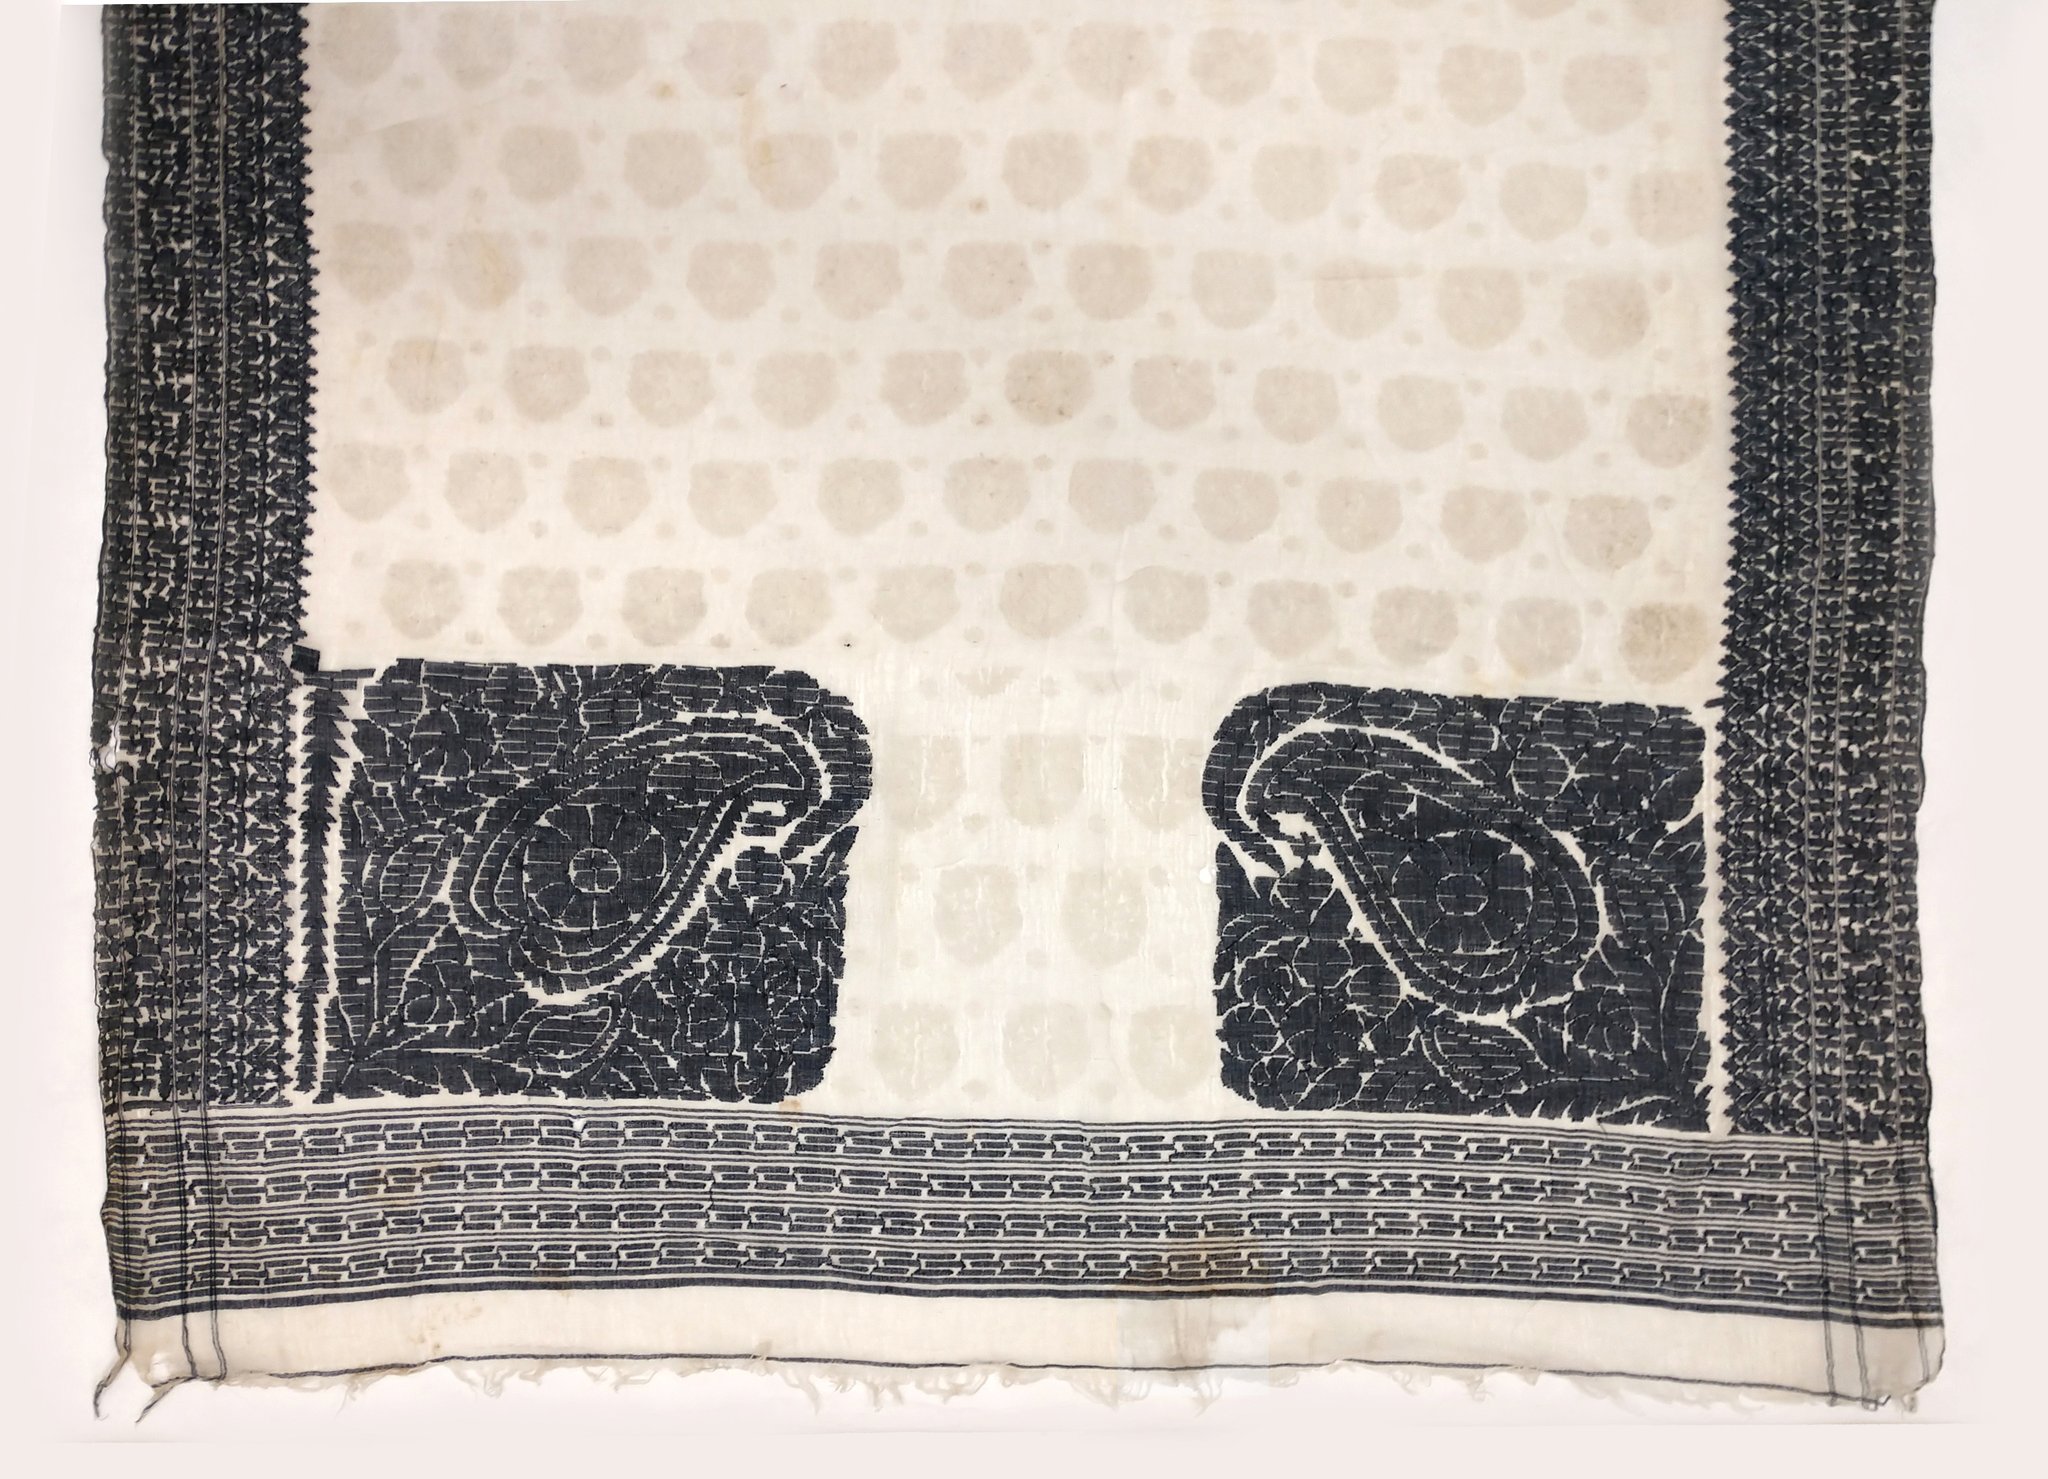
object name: textile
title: Sari-length textile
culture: bangladesh, dacca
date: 1801-1933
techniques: weave